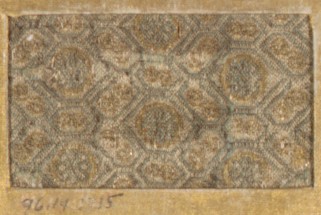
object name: piece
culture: japanese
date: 1701-1900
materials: silk